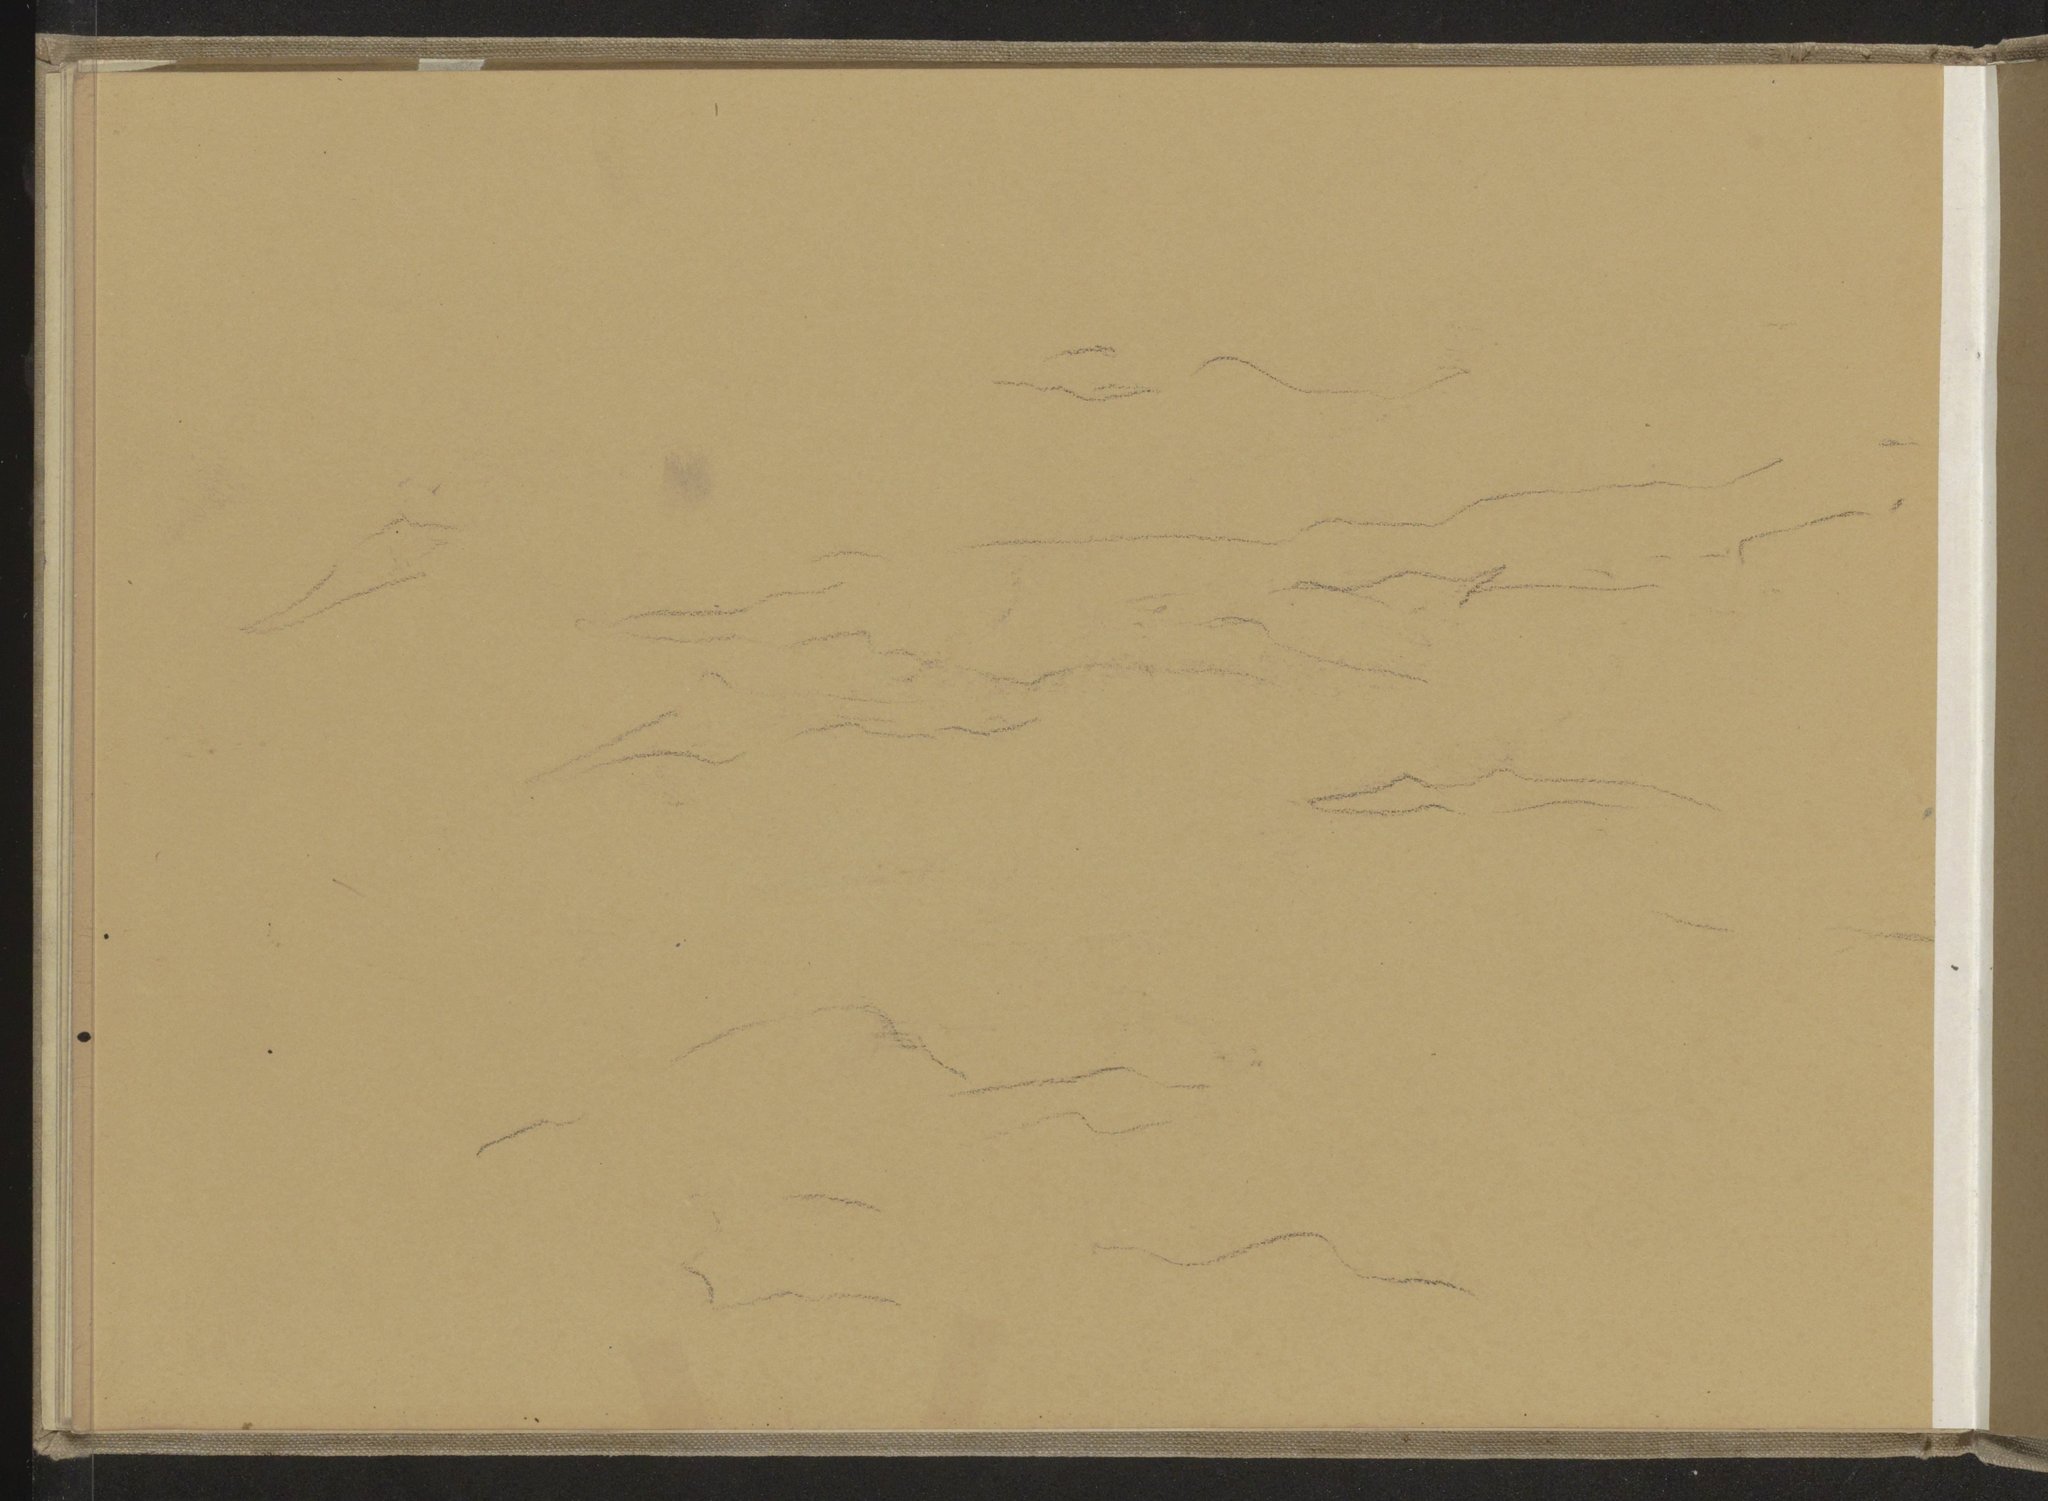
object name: sketchbook leaf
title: Wolken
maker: jozef israëls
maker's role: draughtsman, painter, print maker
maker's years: 1824-1911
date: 1834-1911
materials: chalk, paper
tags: clouds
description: Blad 25 verso uit een schetsboek met 27 bladen.